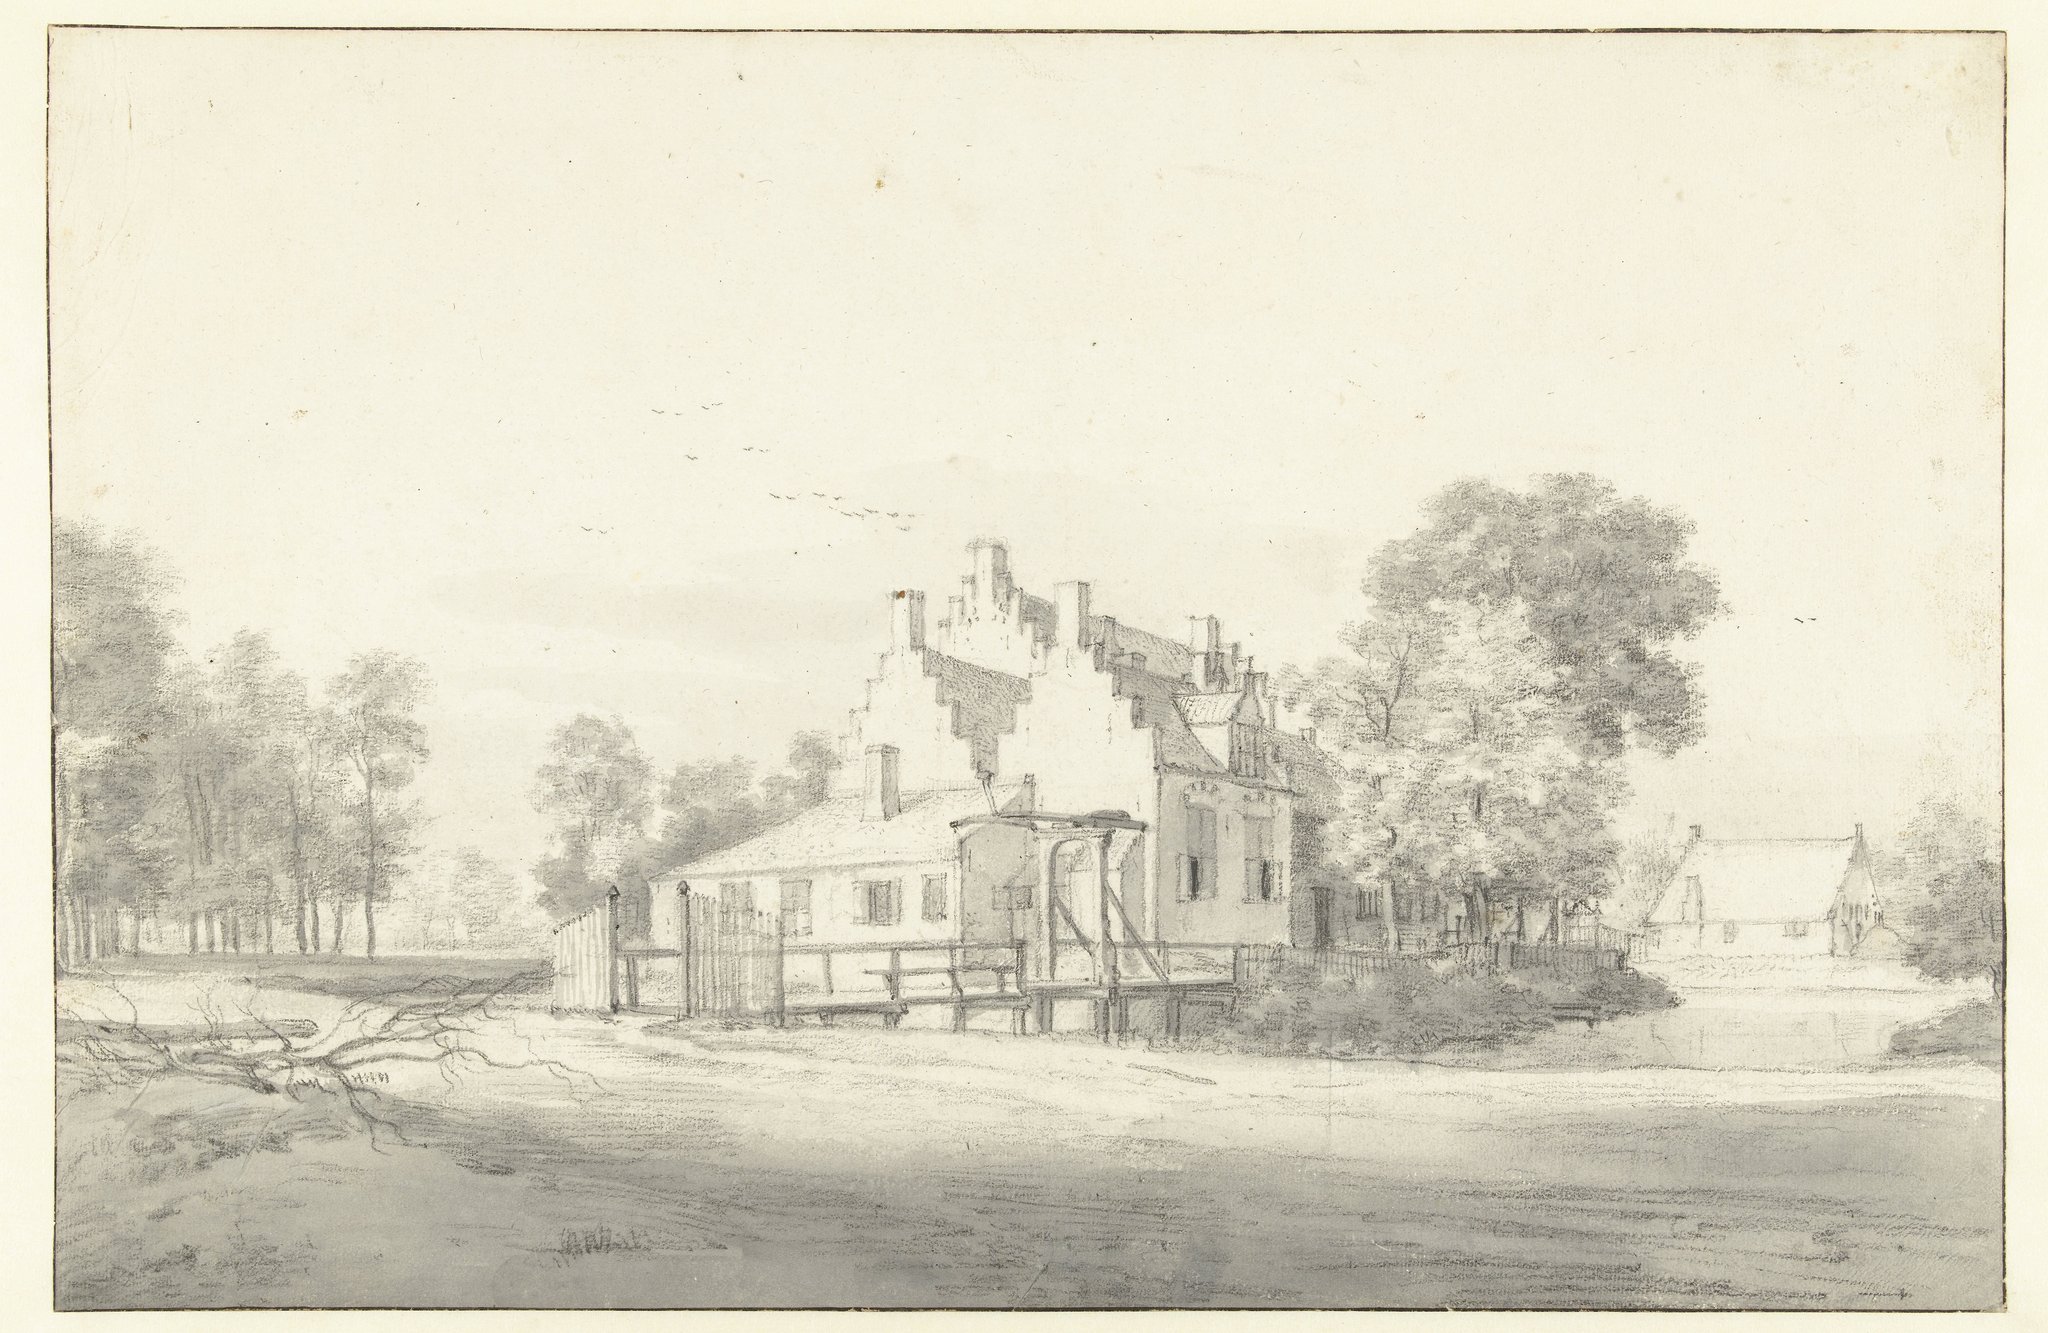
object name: drawing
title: View of Huis Broekhuizen, Seen from the South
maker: roelant roghman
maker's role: draughtsman, painter, print maker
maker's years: 1627-1692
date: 1646-1647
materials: chalk, ink, paper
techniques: brush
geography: kasteel broekhuizen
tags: castle, utrecht, kasteel broekhuizen